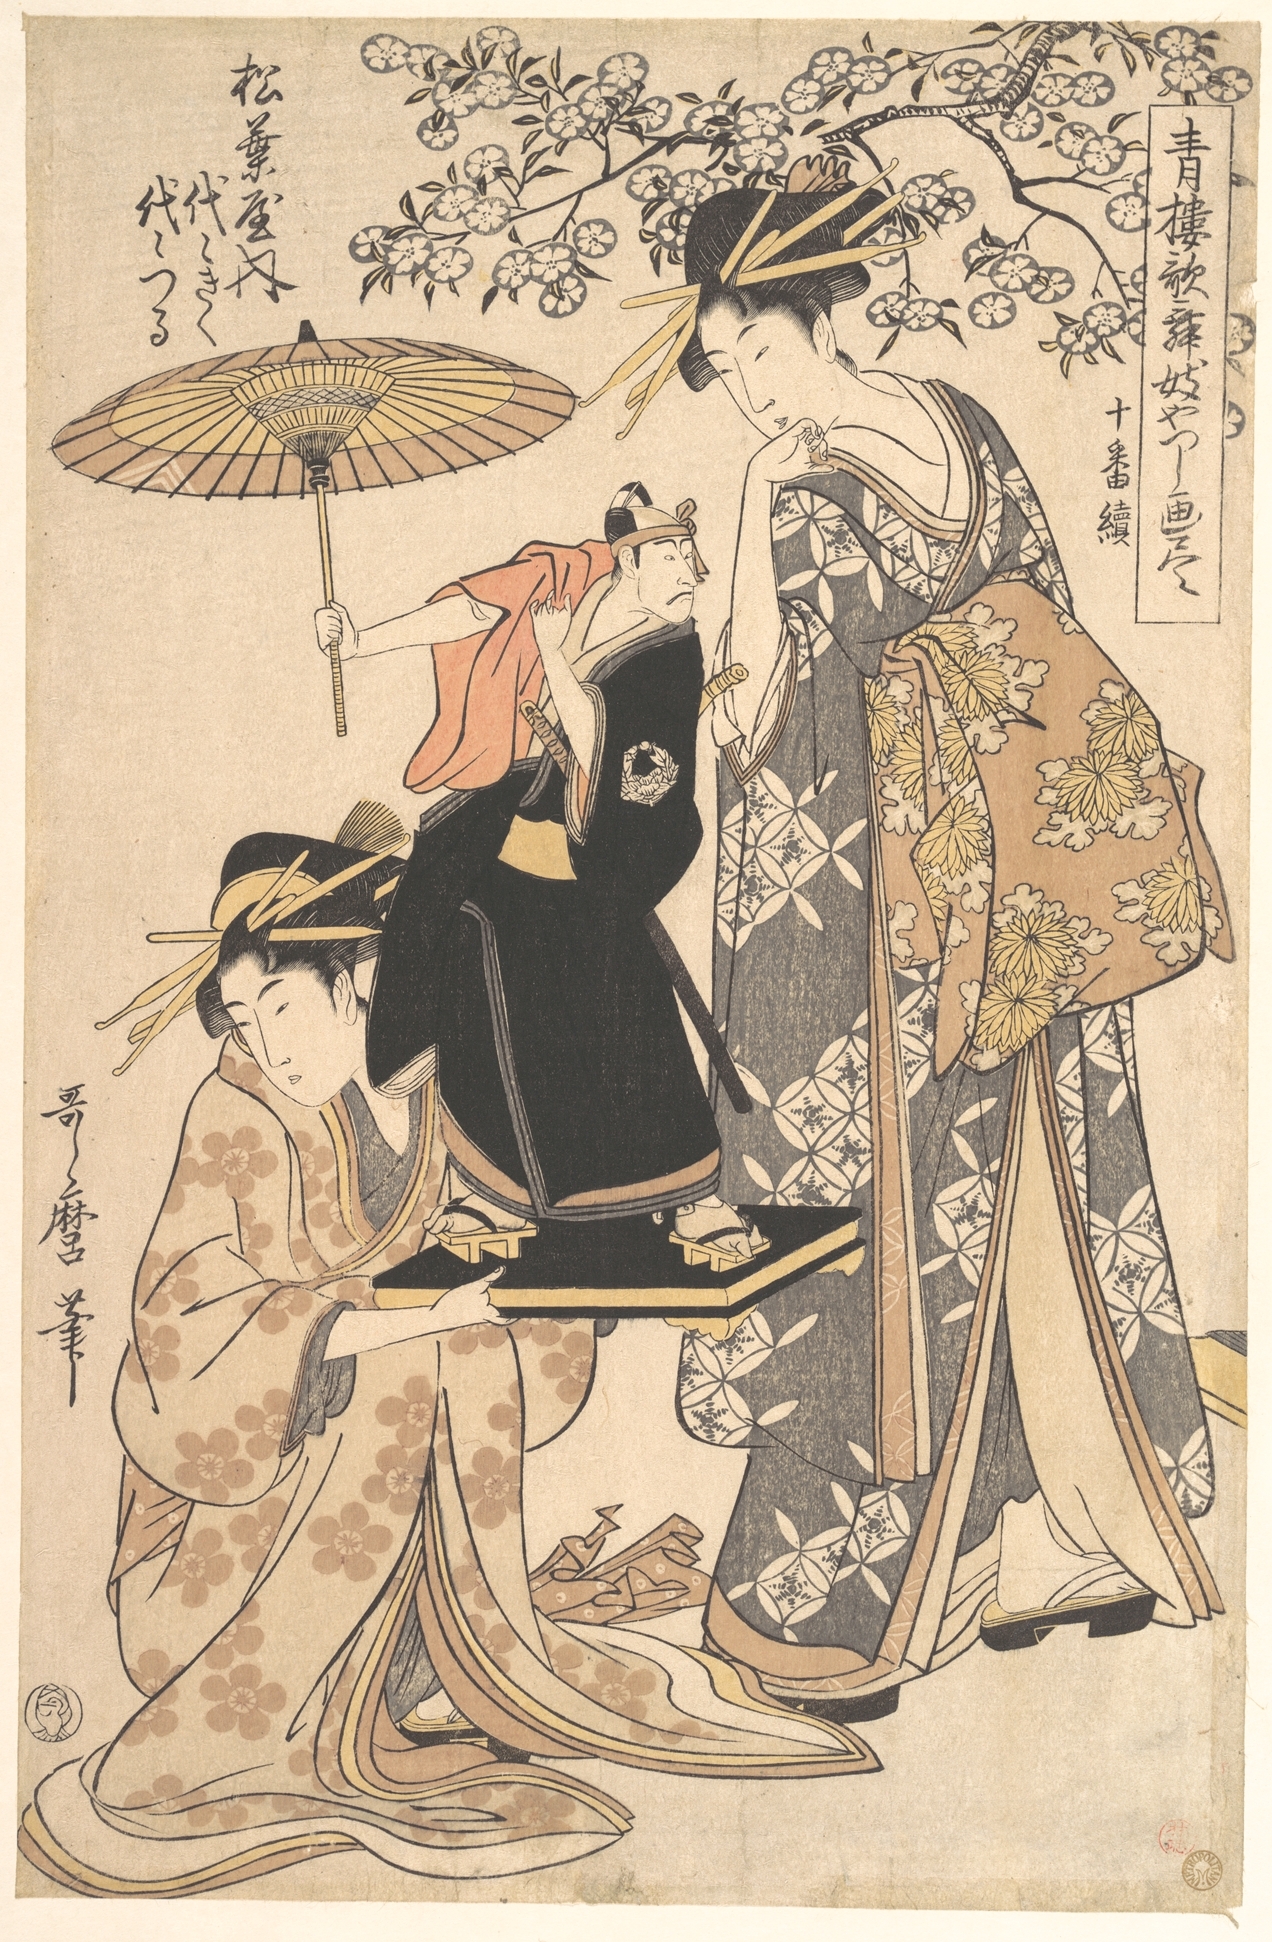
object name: print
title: The Oiran Yoyogiku of Matsubaya Standing under a Cherry Tree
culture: japanese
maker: kitagawa utamaro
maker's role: artist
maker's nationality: japanese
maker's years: 1754-1806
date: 1754-1806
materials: ink, paper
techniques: woodblock print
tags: men,women,trees